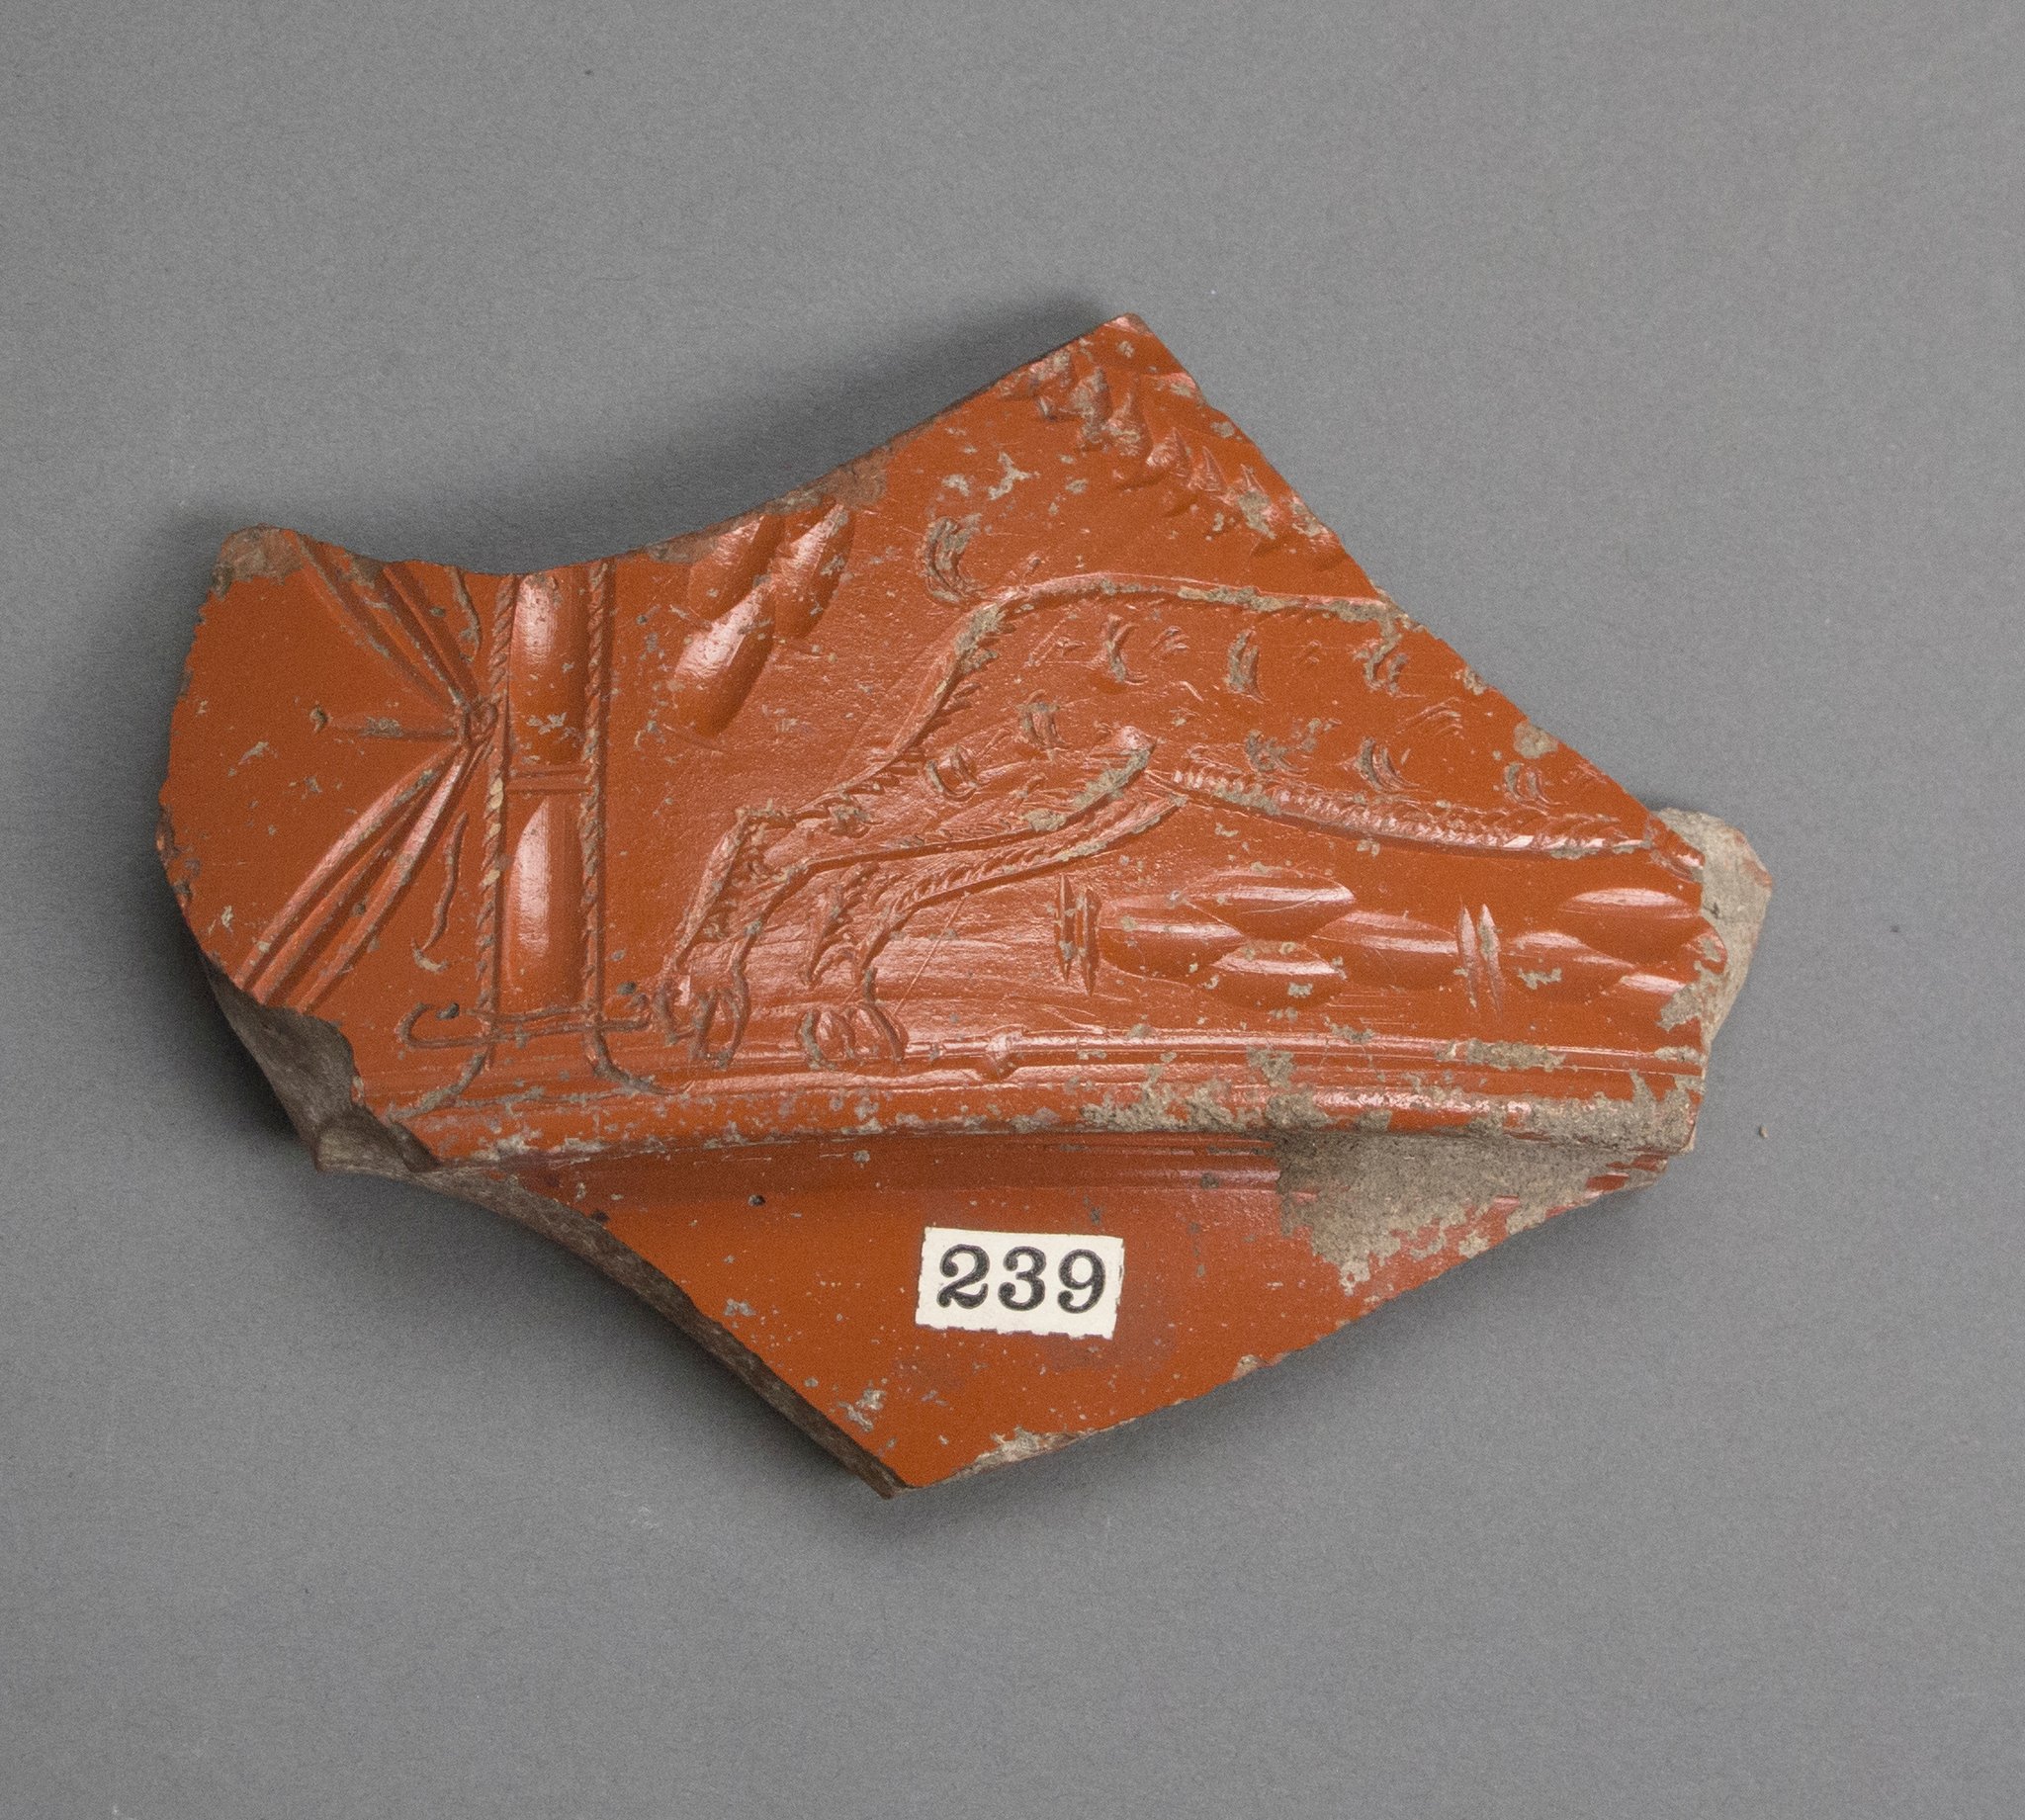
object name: vase fragment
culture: roman, gaul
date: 120 BCE-300 CE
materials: terracotta